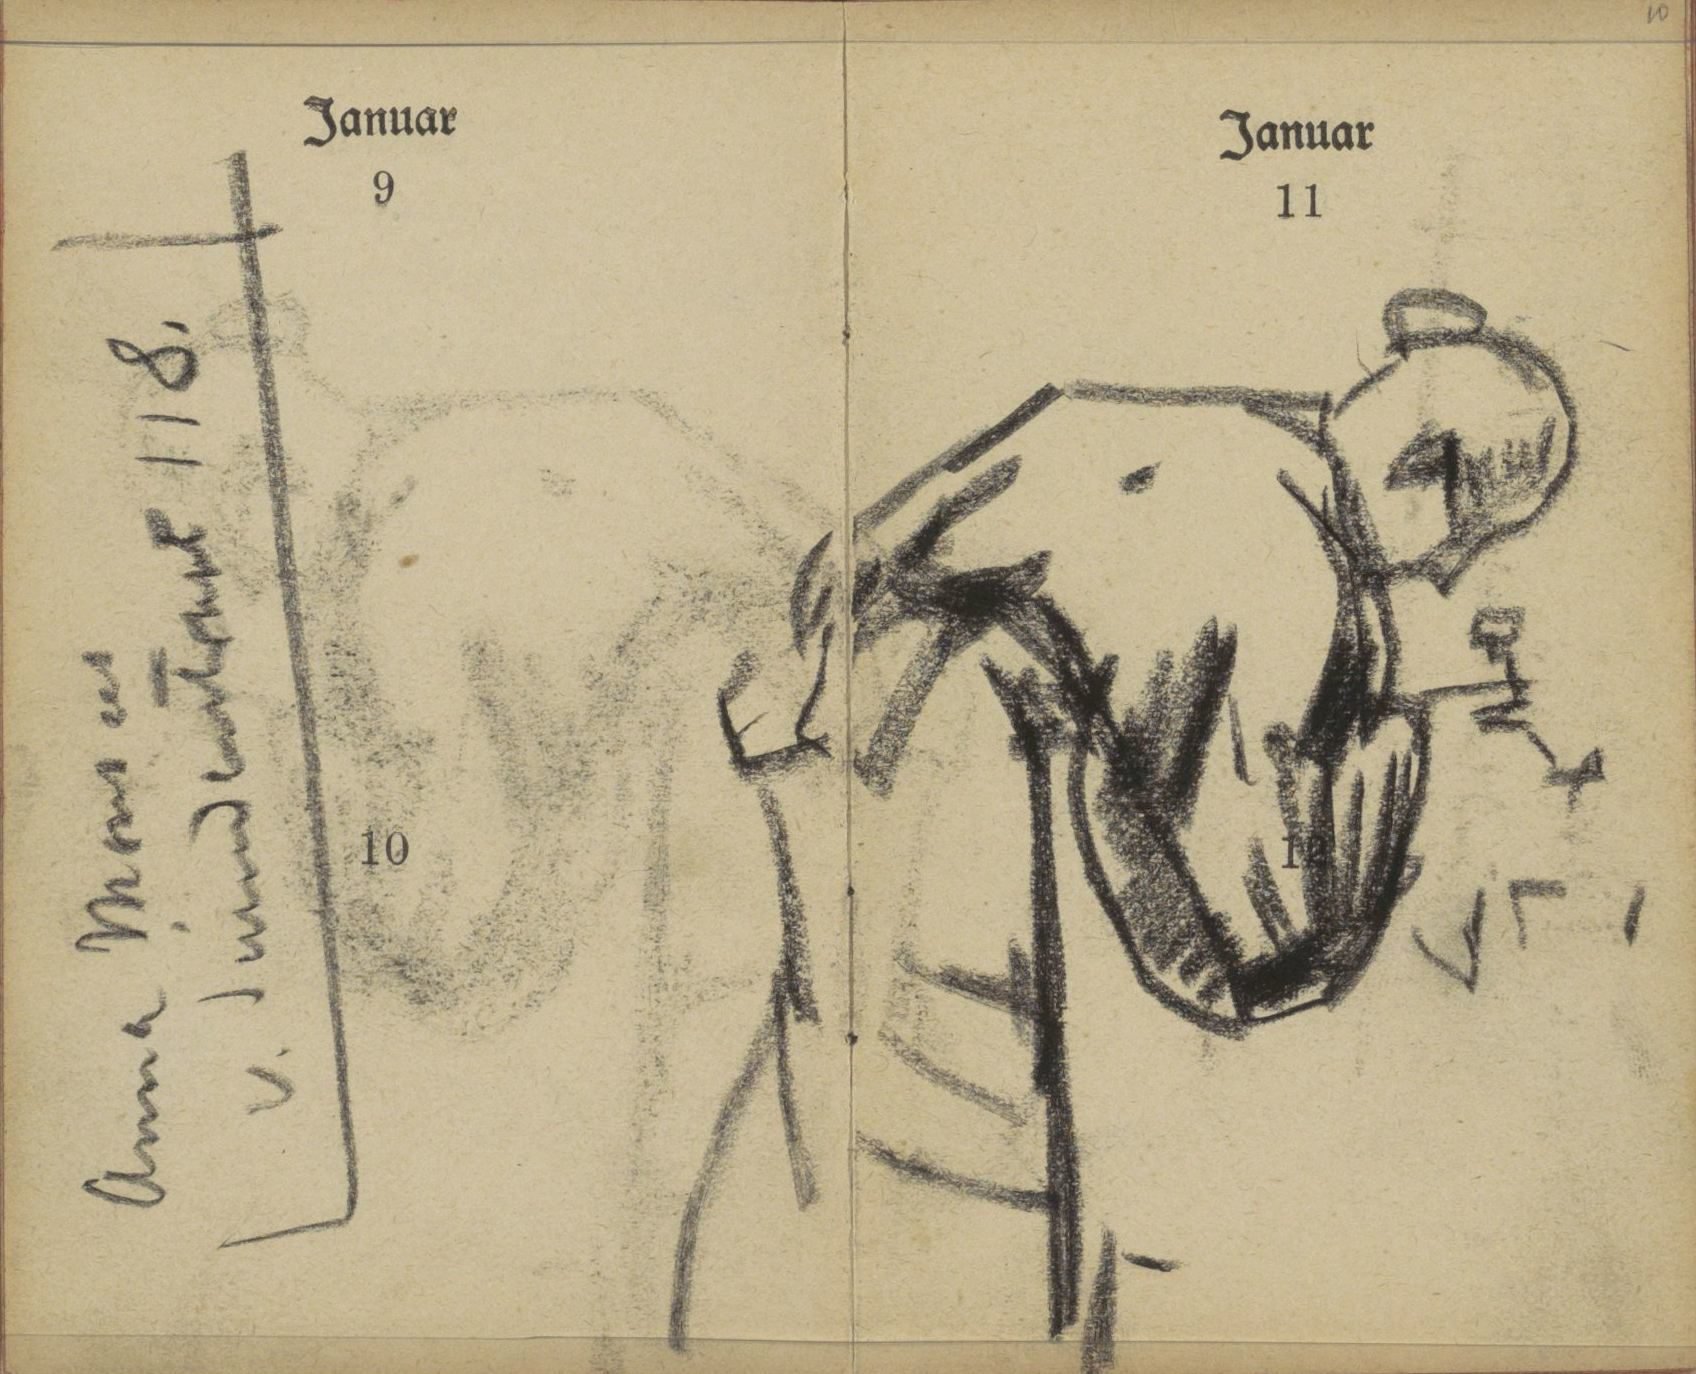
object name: sketchbook leaf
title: Bukkende vrouw in kimono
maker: george hendrik breitner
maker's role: draughtsman, painter, print maker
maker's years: 1857-1923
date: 1893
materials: chalk, paper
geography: amsterdam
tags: folk costume, regional costume (+ women's clothes), bending figure - aa - female human figure (+ sideview, profile)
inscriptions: annotation: ‘Anna Monsees[?]/ v. Swindenstraat 118.’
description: Pagina 9 en pagina 10 uit een als schetsboek gebruikte agenda met 80 bladen.